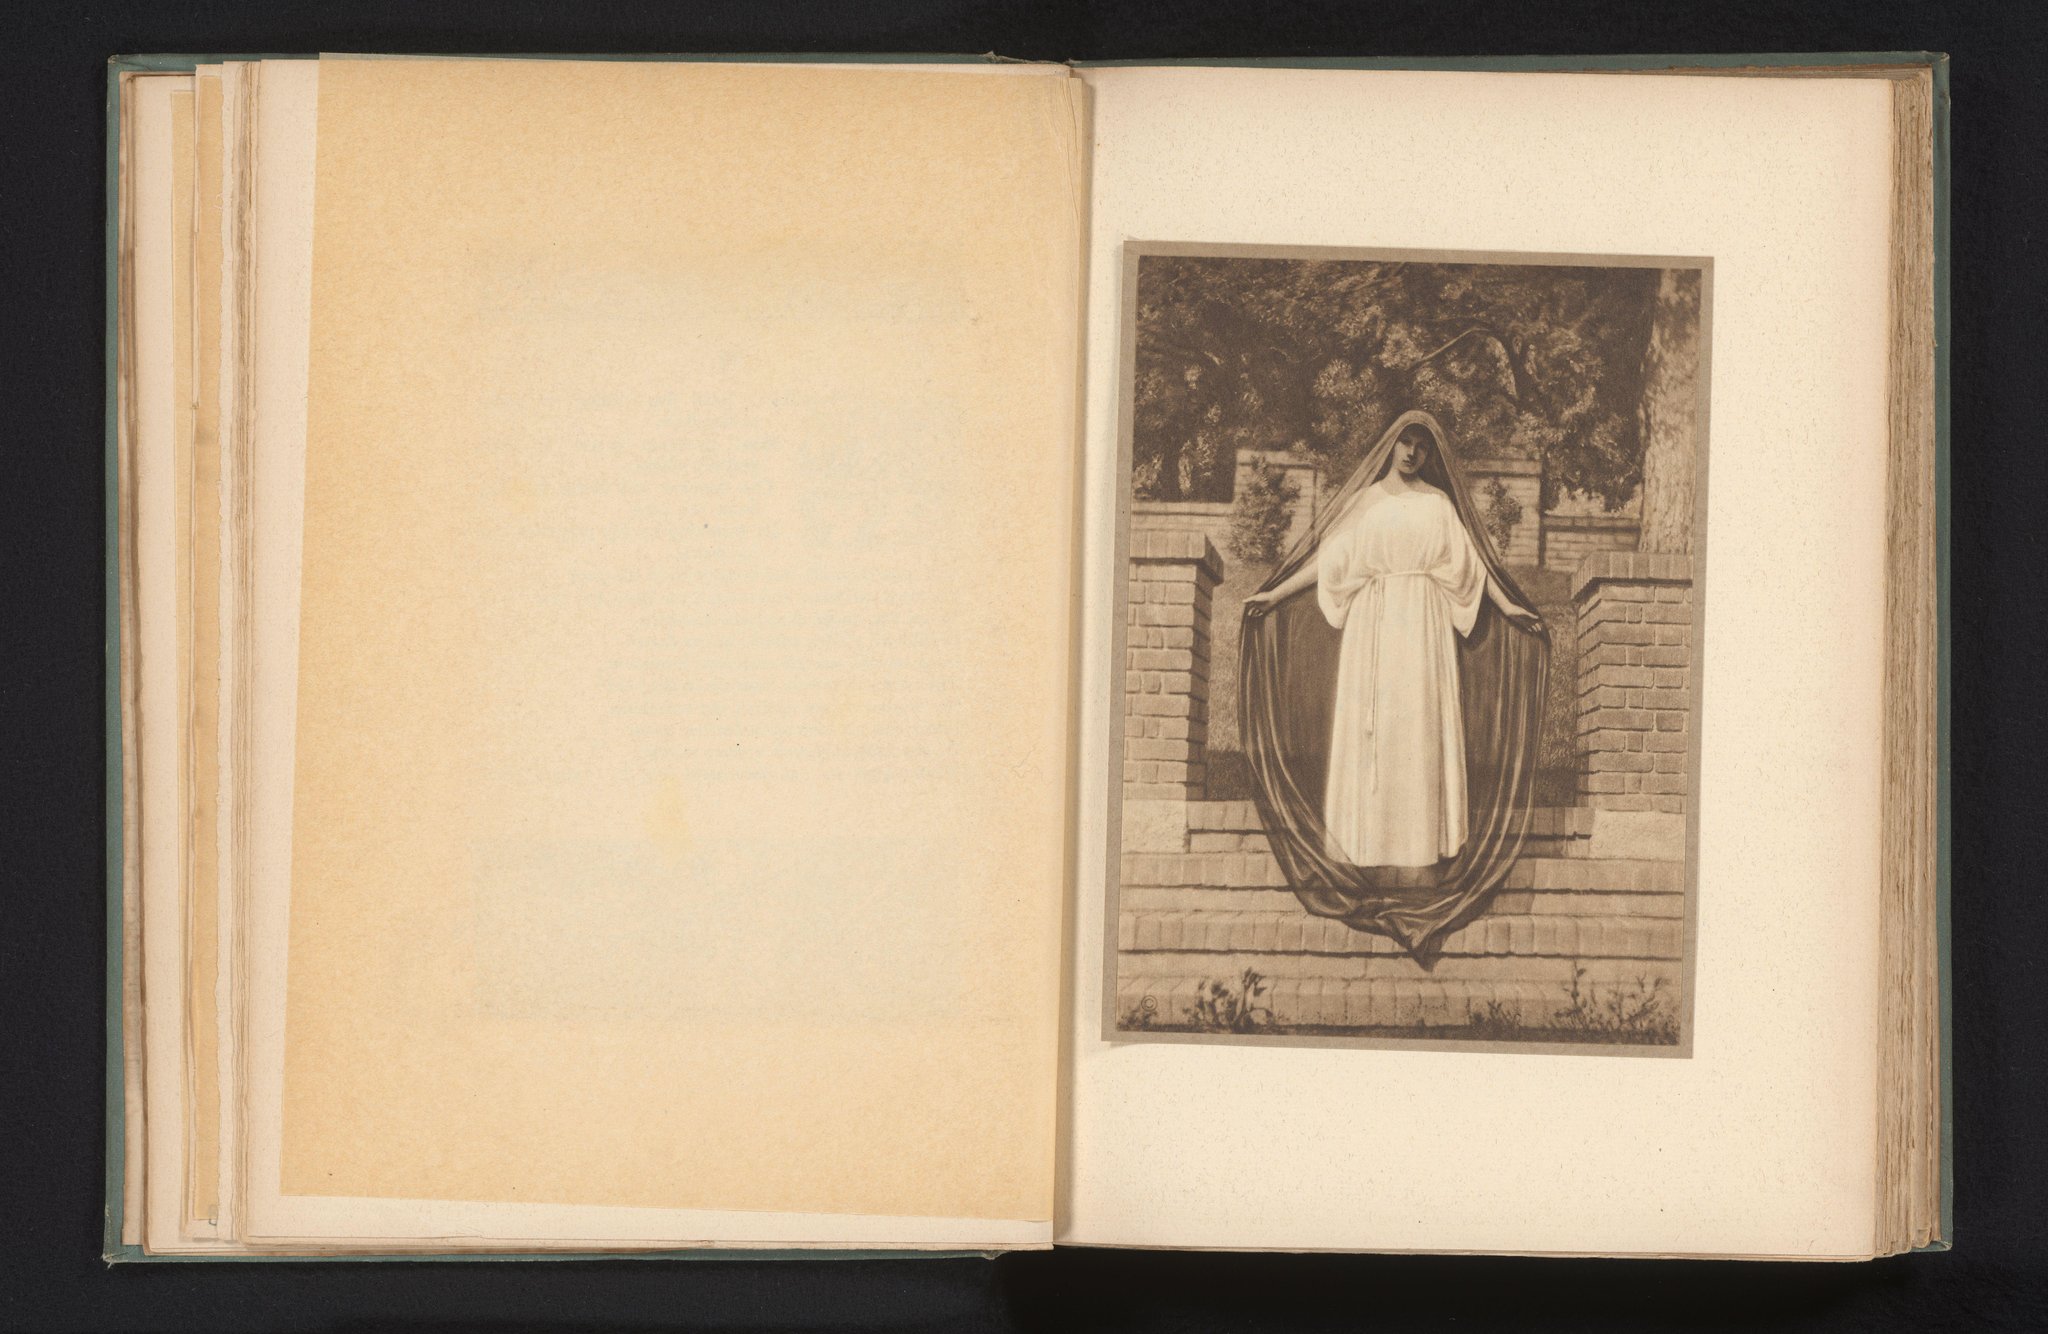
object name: photomechanical print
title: Vrouw zwevend boven een trap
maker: adelaide hanscom leeson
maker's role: painter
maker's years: 1875-1931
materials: cardboard, paper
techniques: photoaquatint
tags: adolescent, young woman, maiden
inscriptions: copyright notice: ‘C’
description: Prent op ongenummerde pagina. Adelaide Hanscom Leeson manipuleerde haar glasnegatieven om een schilderachtig efffect te bewerkstelligen.